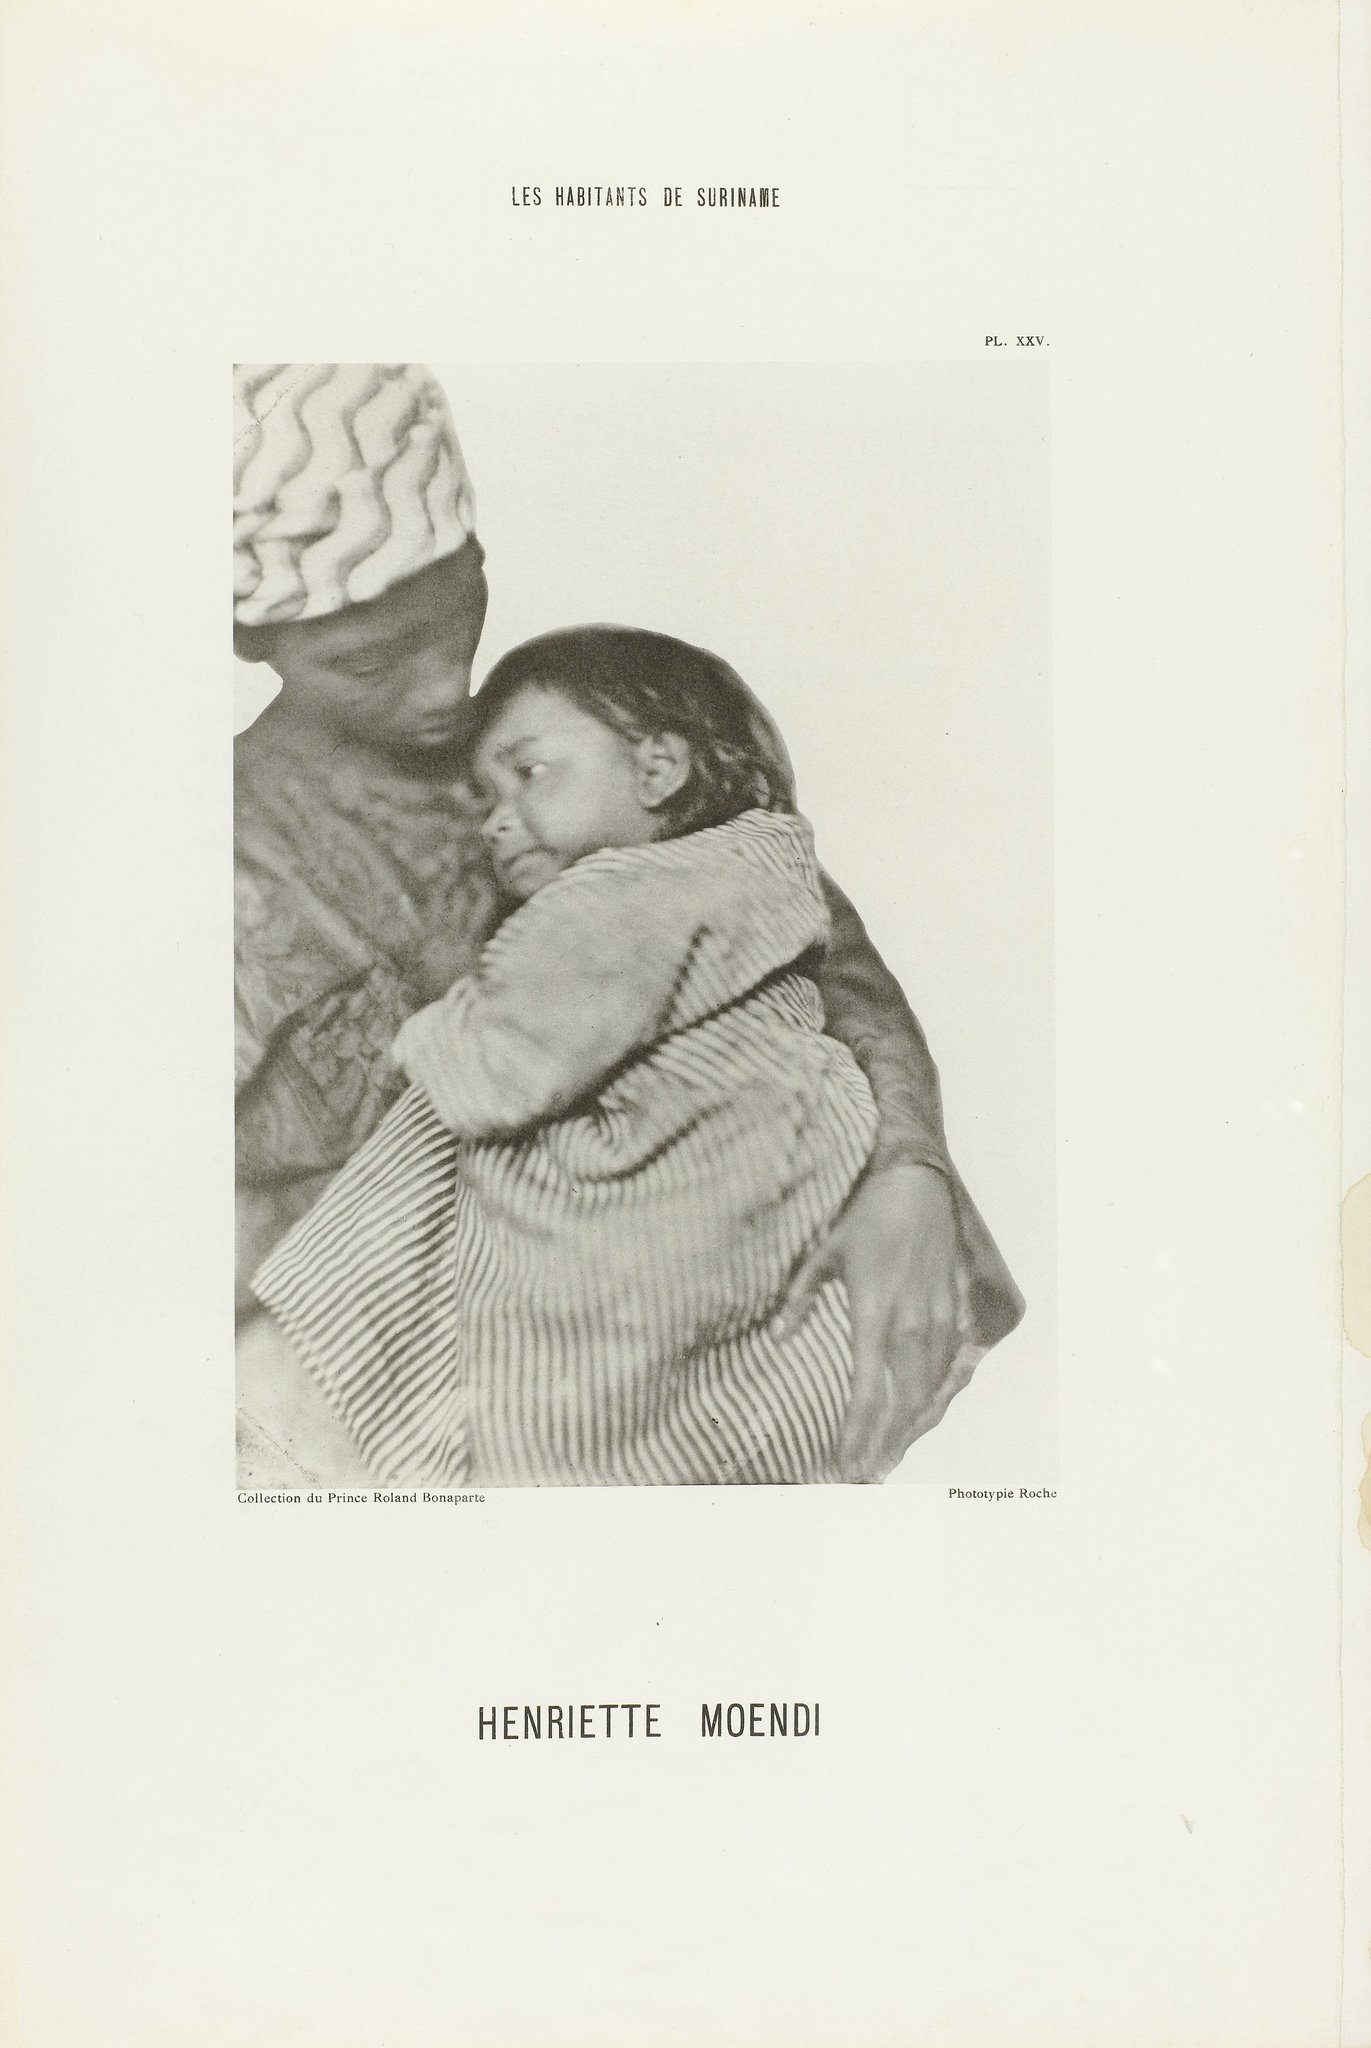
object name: page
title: Portret van Henriette Moendi, met een onbekende vrouw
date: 1883-1884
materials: paper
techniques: photograph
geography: amsterdam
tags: historical persons, infant, baby ~ the ages of man, amsterdam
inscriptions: inscription: ‘Collection du Prince Roland Bonaparte/ Phototypie Roche’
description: Portret van Henriette Moendi, dochter van de Hindostaanse Elisabeth Moeti en haar Caraïebse man uit Suriname, gefotografeerd op de Internationale Koloniale en Uitvoerhandel Tentoonstelling, Amsterdam 1883. De vrouw is mogelijk haar moeder Elisabeth.